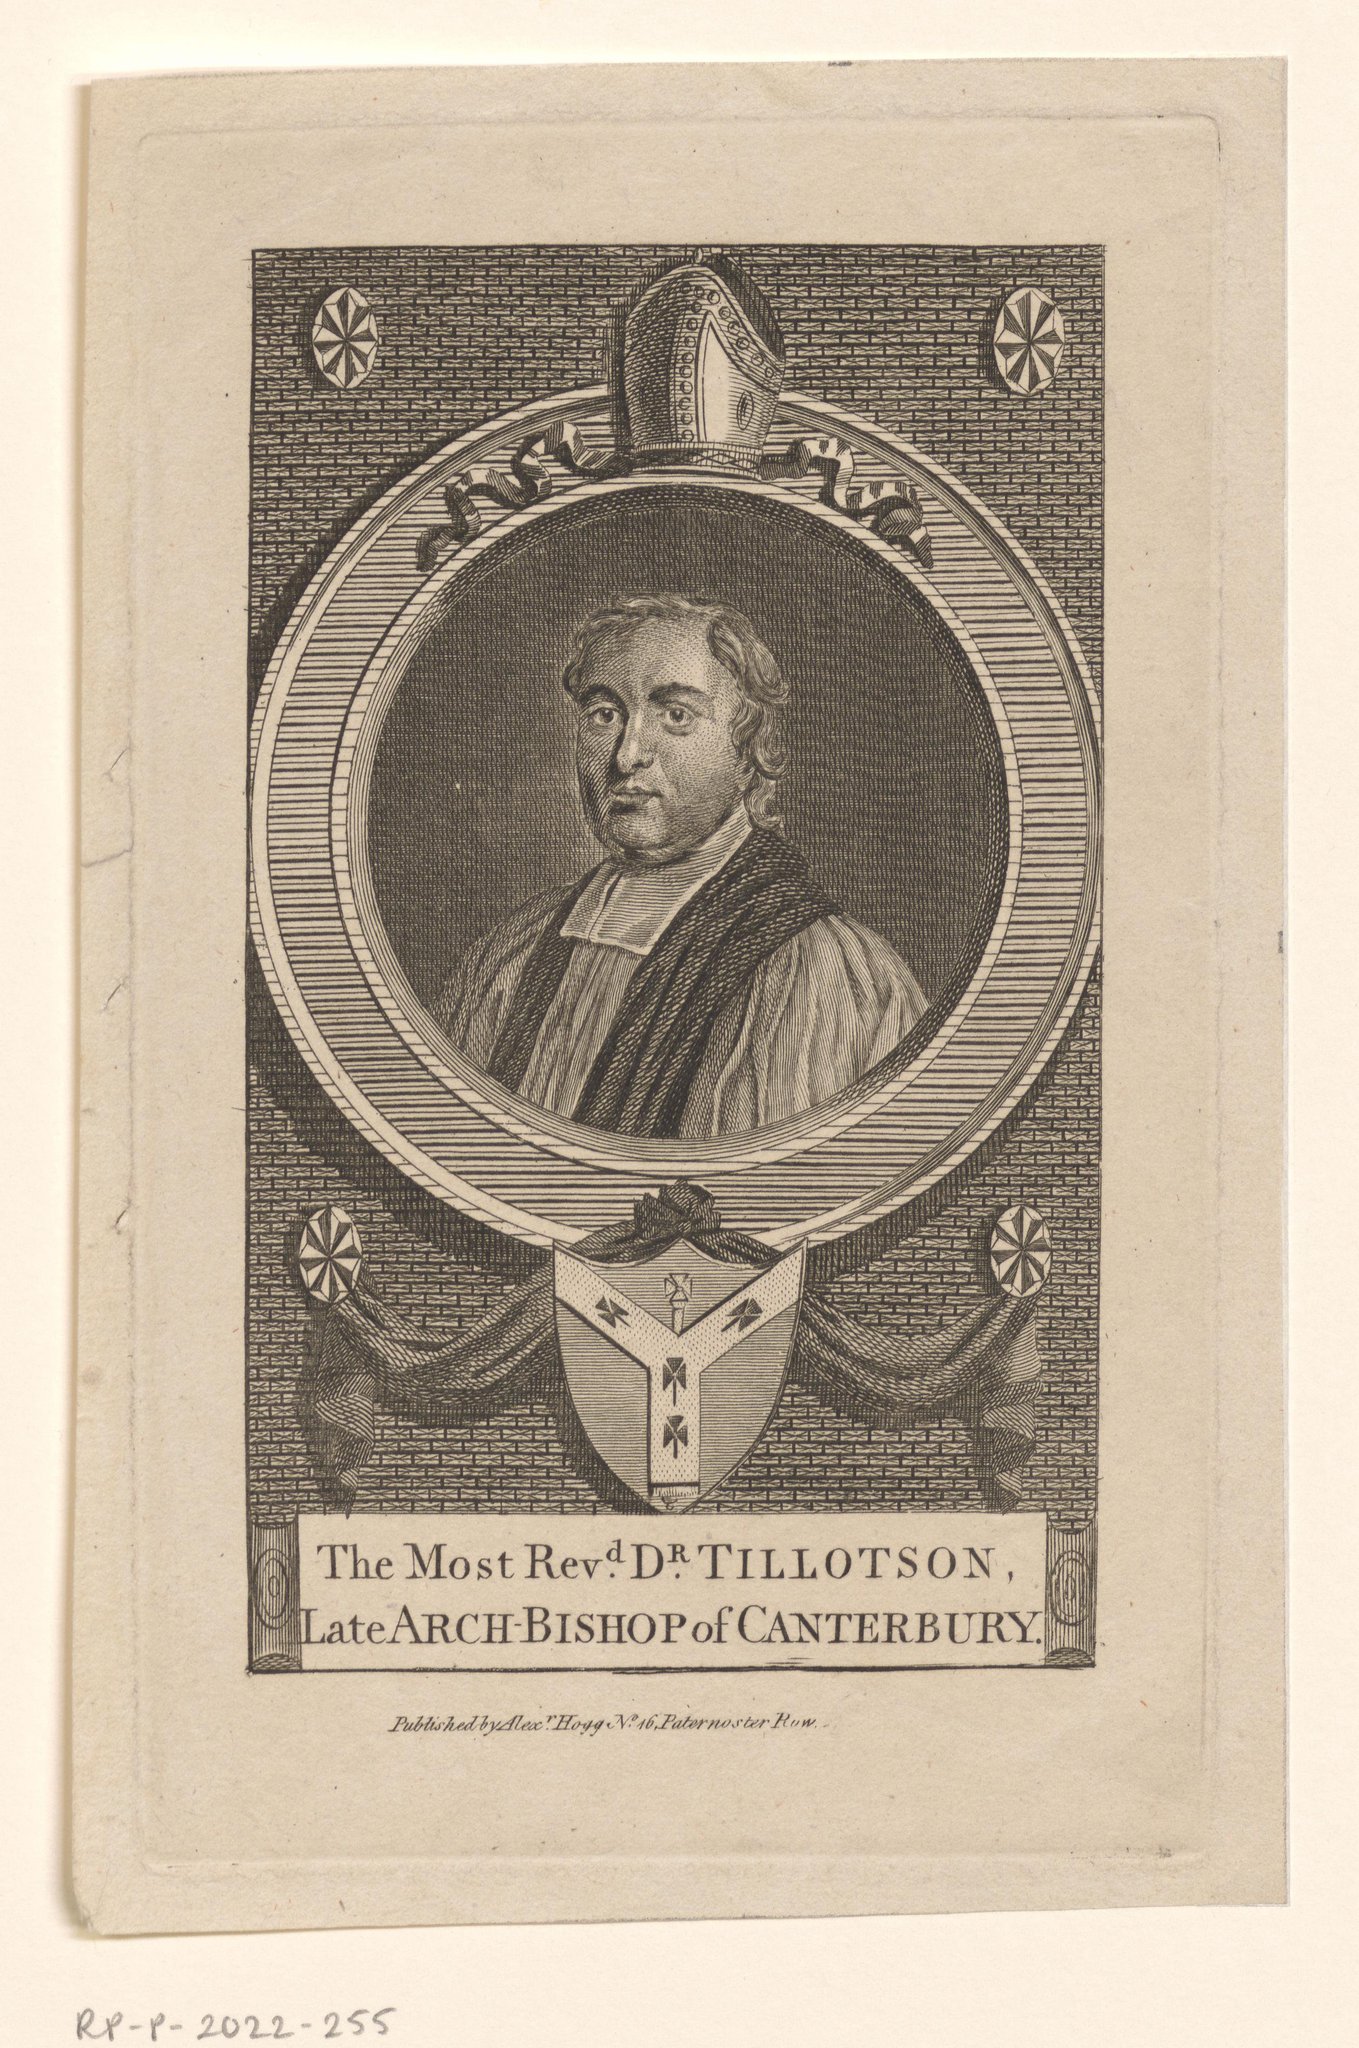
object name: print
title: Portret van John Tillotson, aartsbisschop van Canterbury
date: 1789-1824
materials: paper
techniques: engraving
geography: london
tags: clergyman, archbishop, bishop, etc. (roman catholic), historical persons, armorial bearing, heraldry